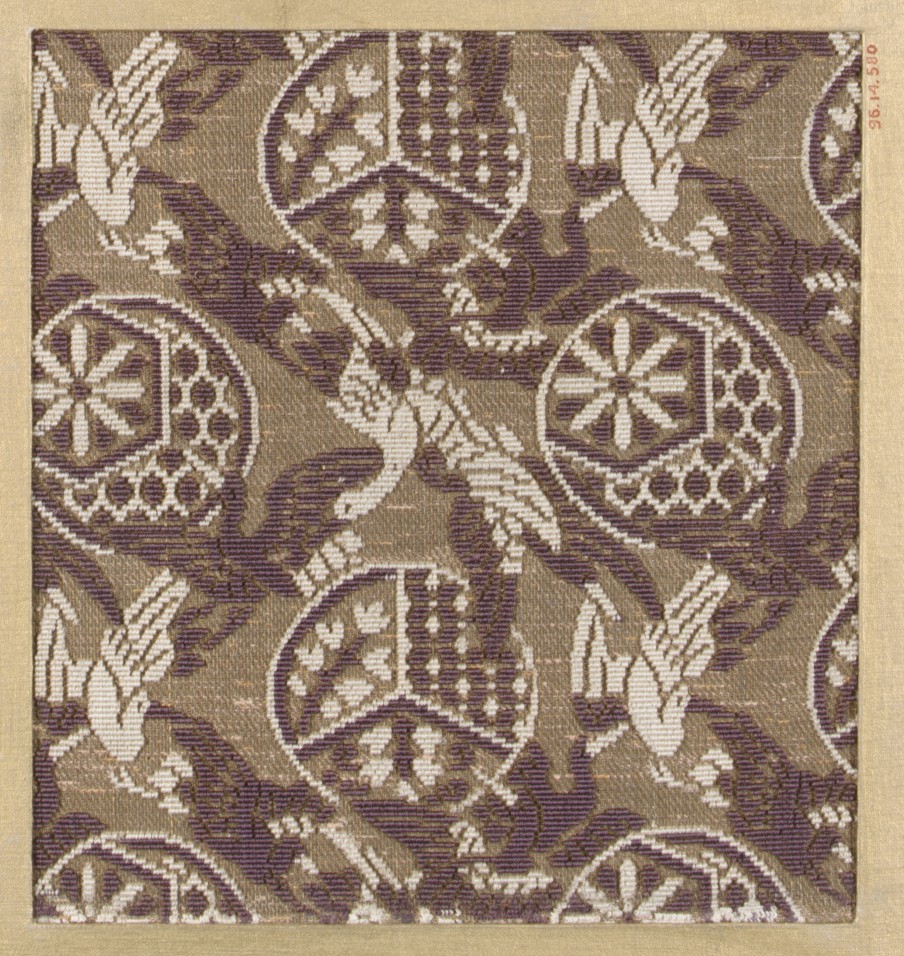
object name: piece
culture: japanese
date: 1701-1900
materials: silk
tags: flowers